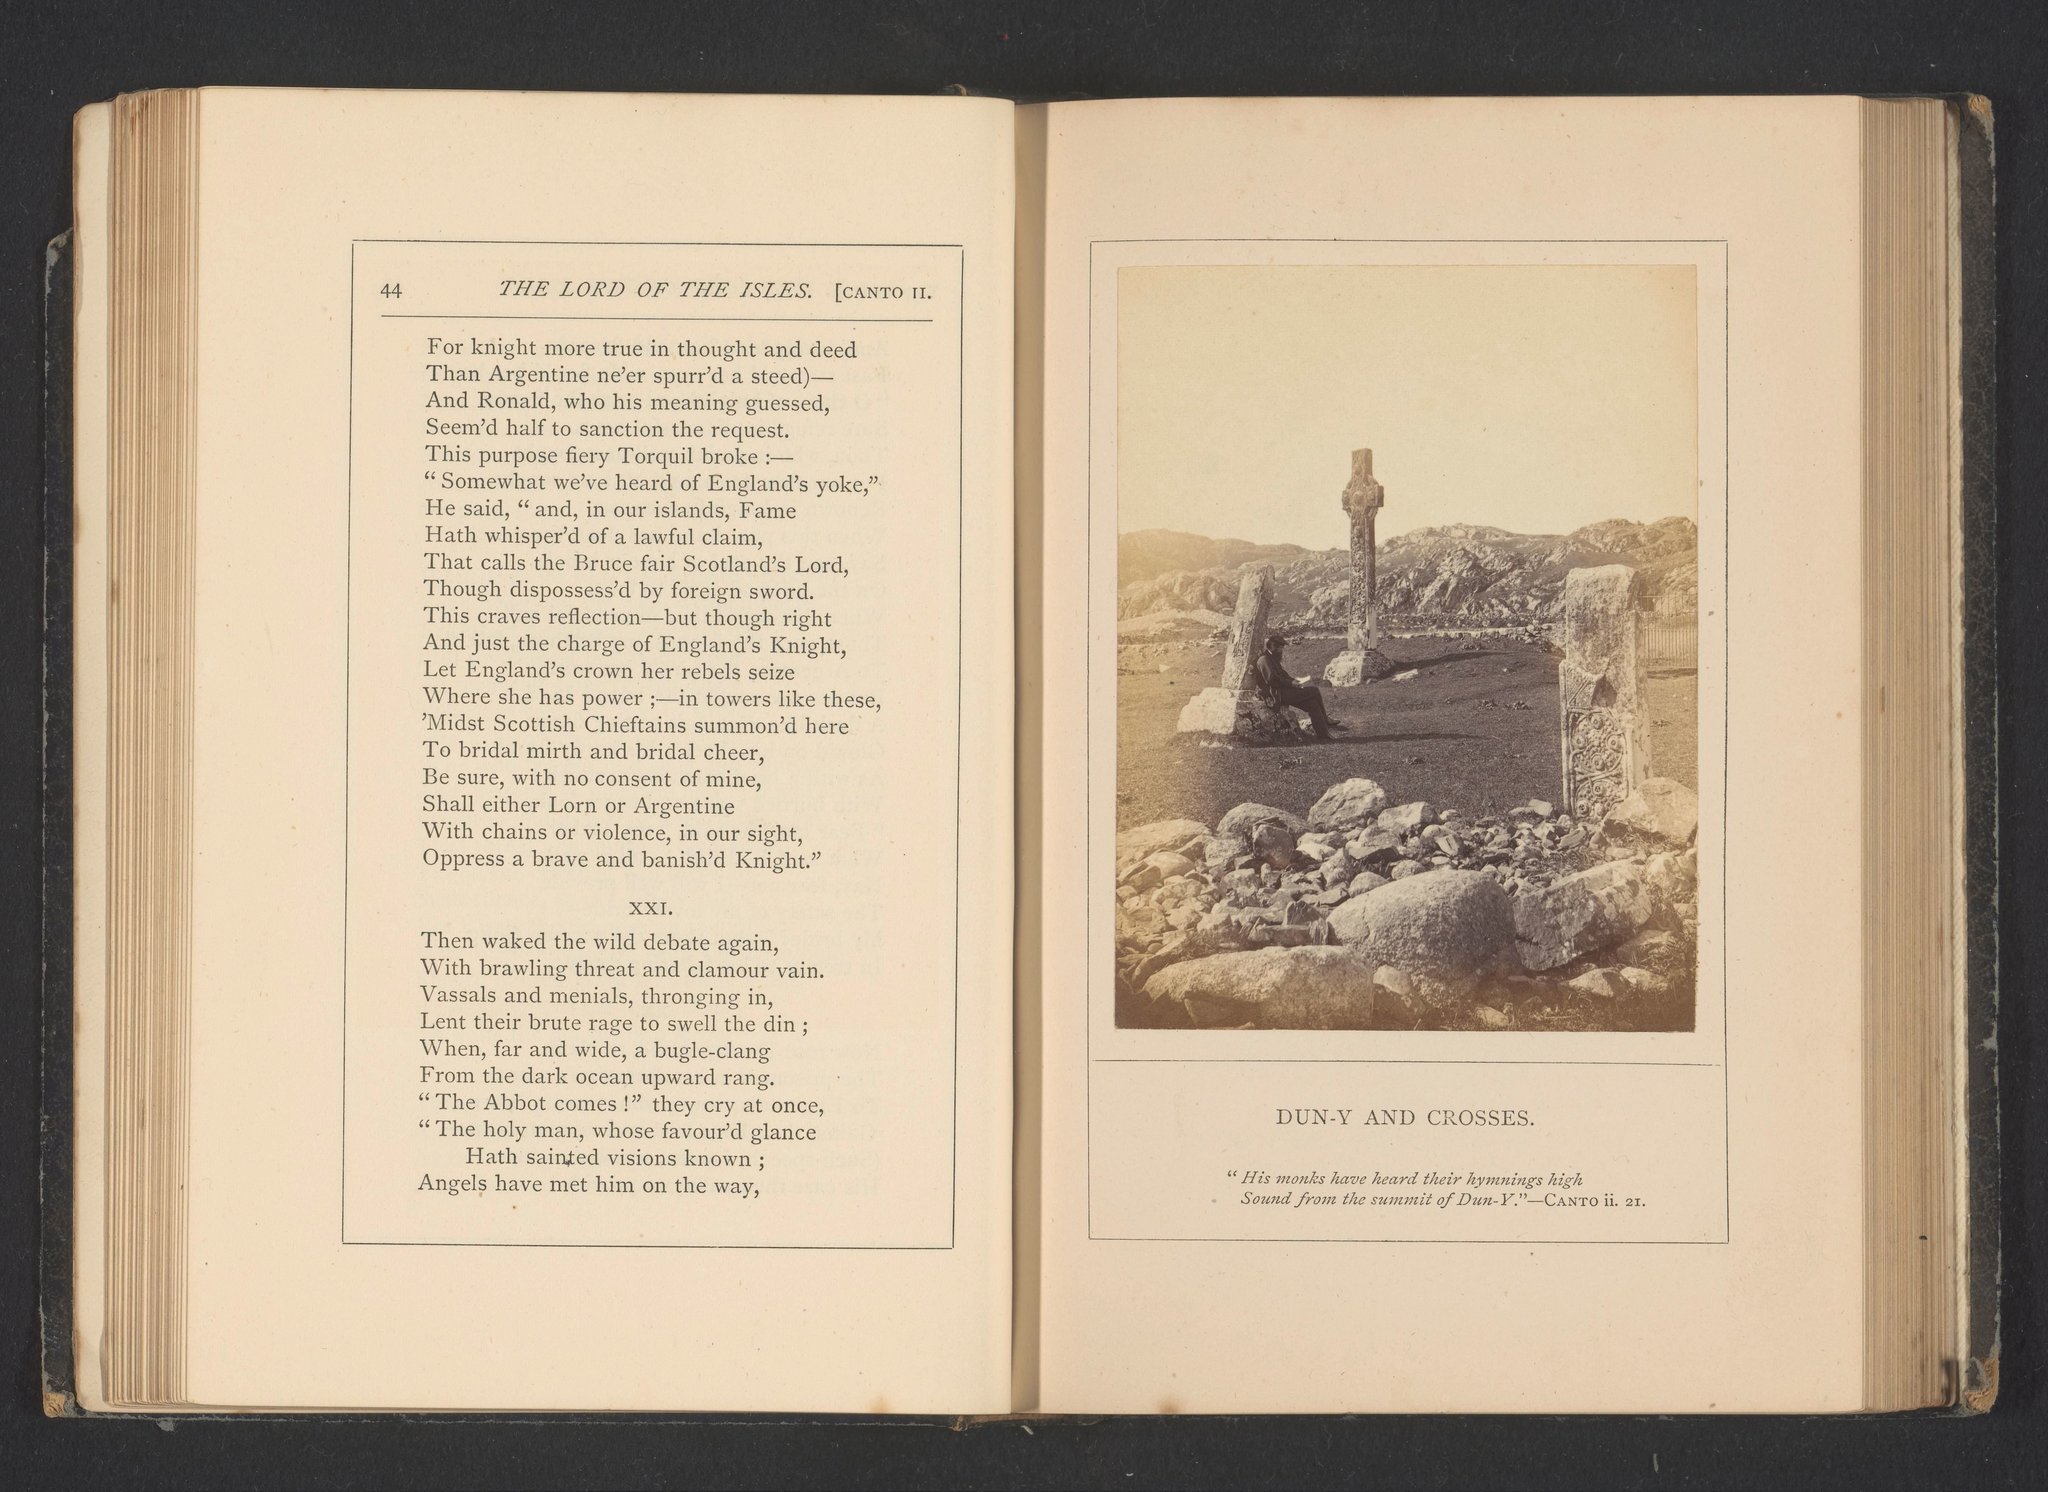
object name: photograph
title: Dun-y and crosses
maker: Anonymous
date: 1861-1871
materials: photographic support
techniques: albumen print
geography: ireland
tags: mountains, specific forms of the cross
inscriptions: inscription: ‘"His Monks (...) Canto ii. 21.’